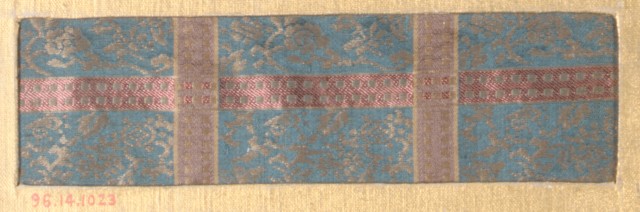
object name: piece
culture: japanese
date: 1701-1900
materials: silk